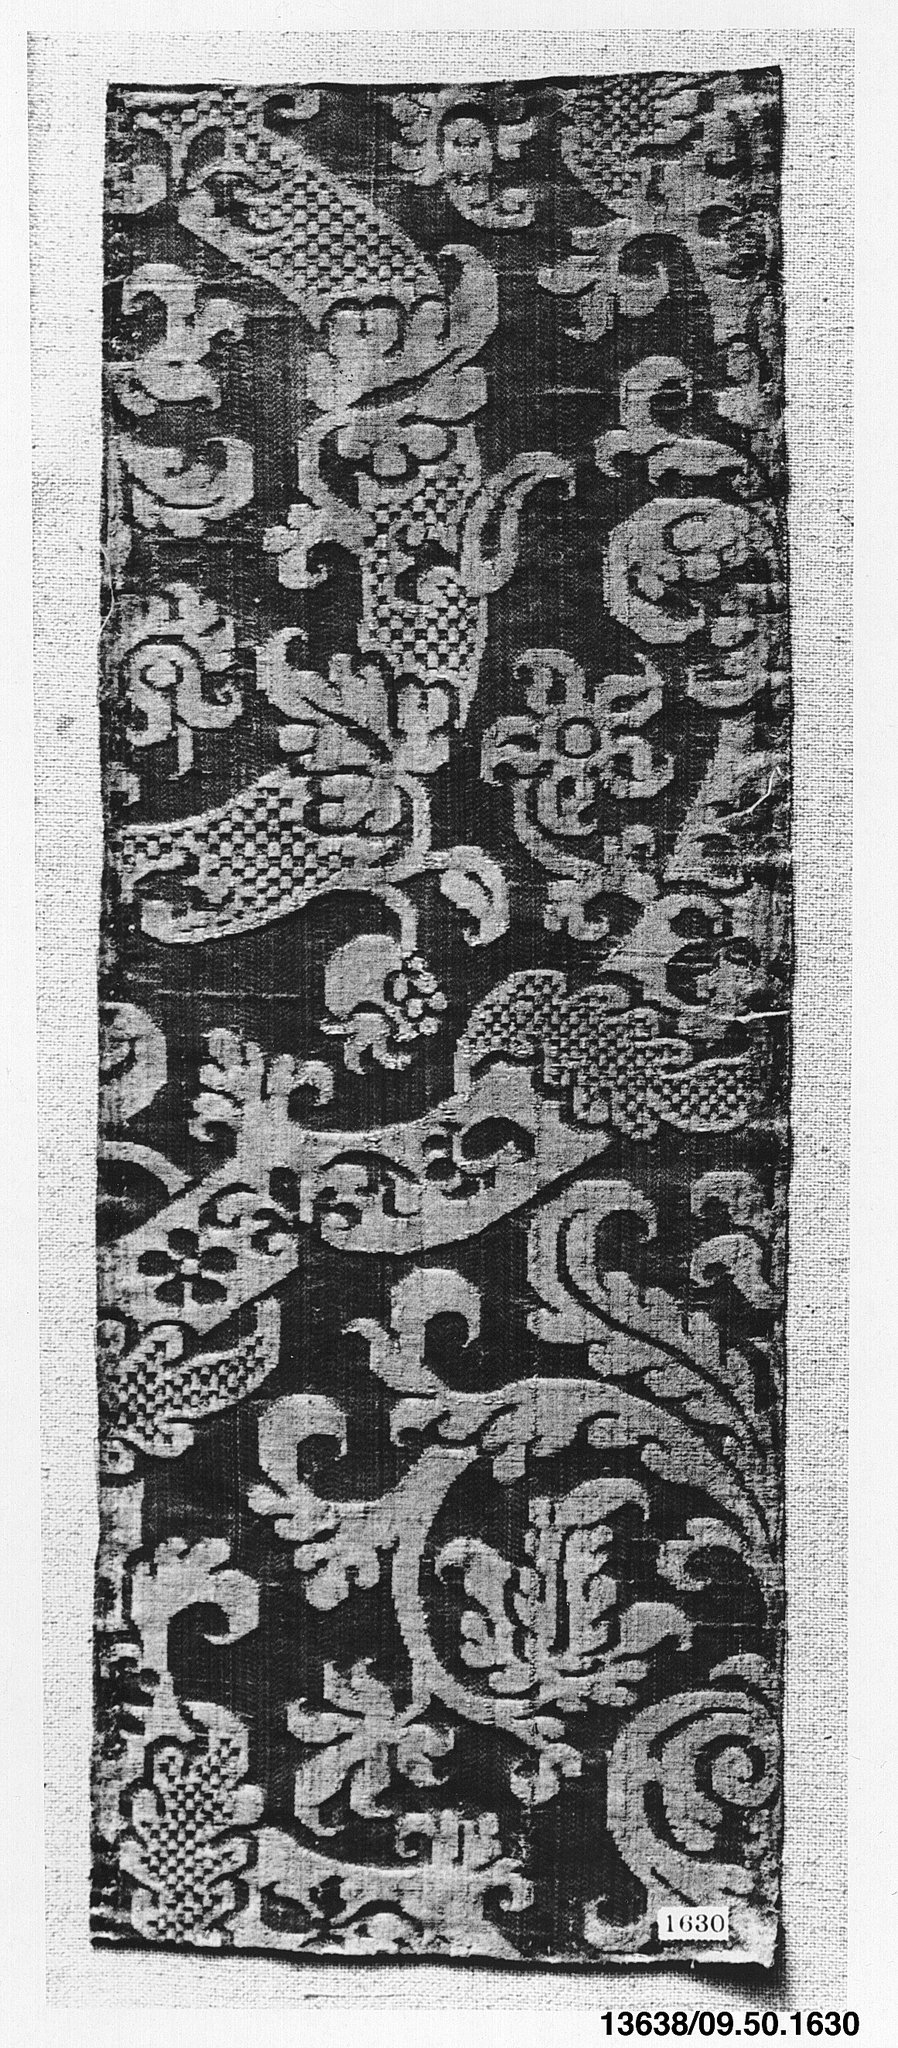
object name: piece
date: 1501-1600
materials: silk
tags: leaves